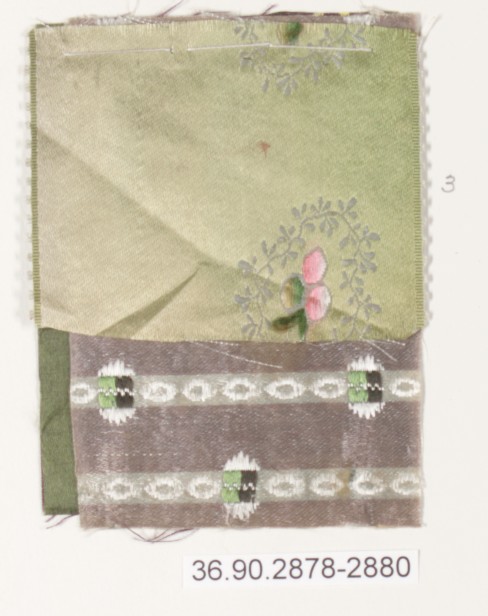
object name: piece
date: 1801-1900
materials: silk